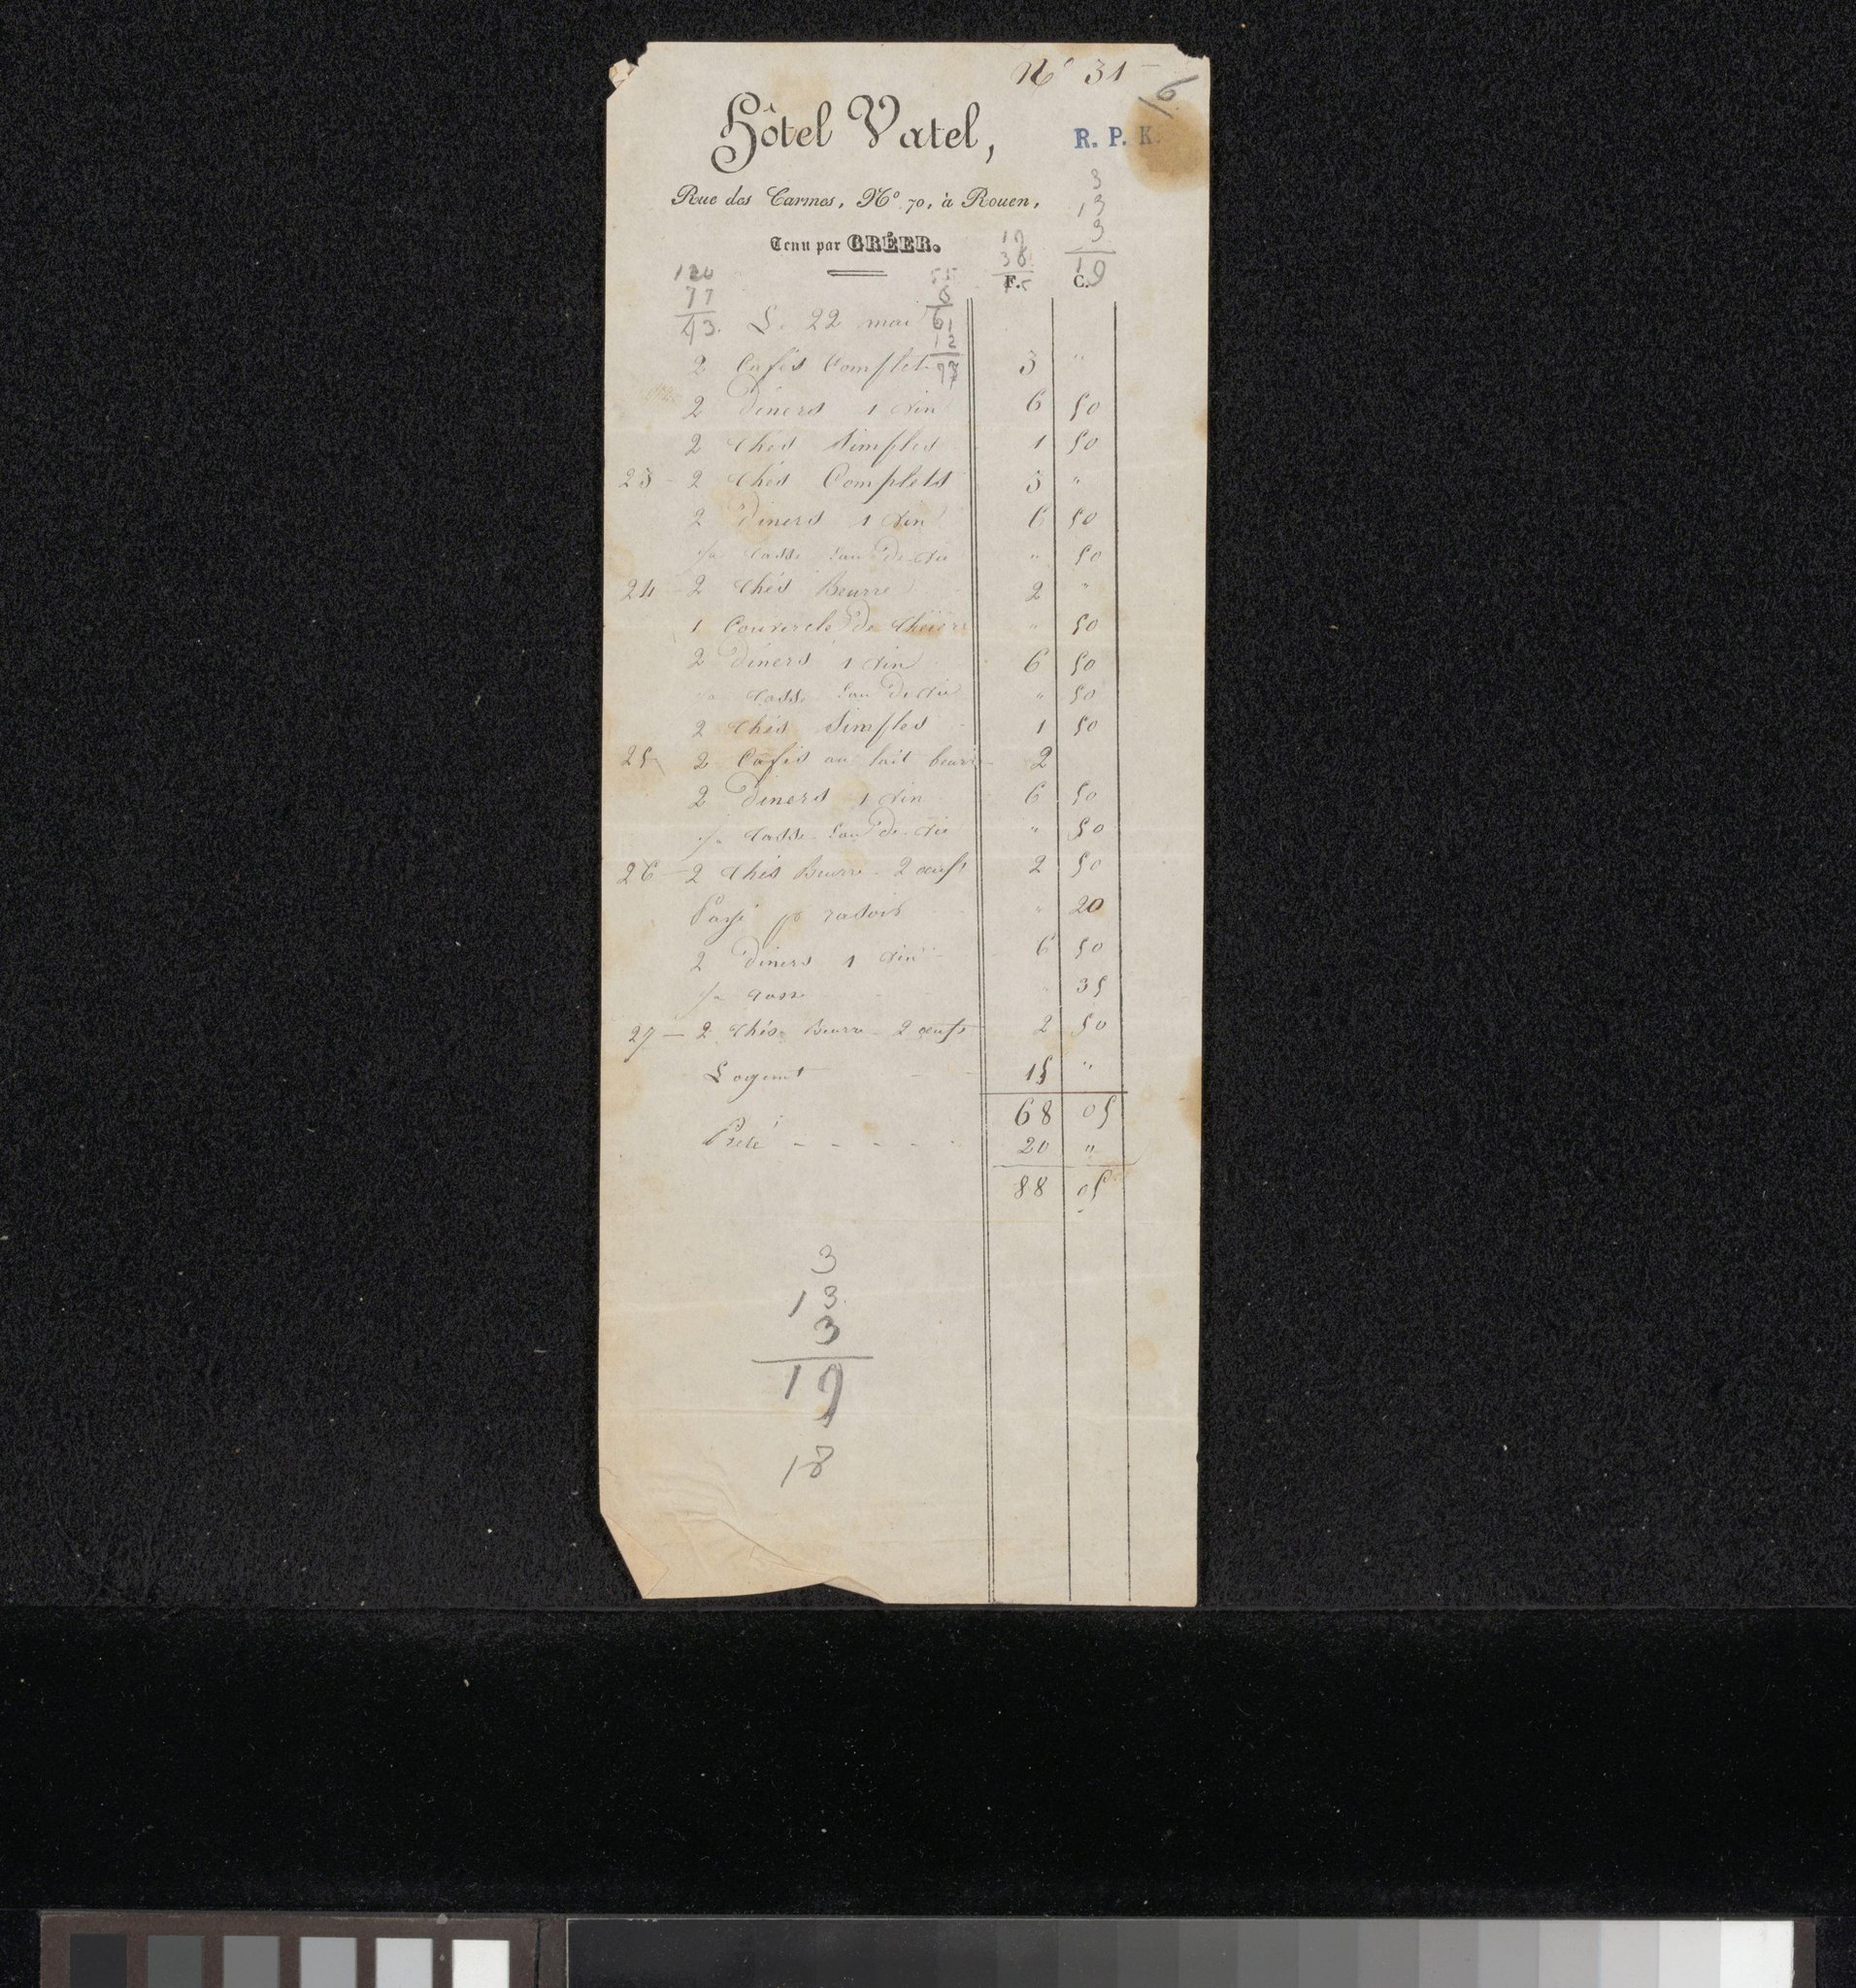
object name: account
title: Rekening voor Huib van Hove Bz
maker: Anonymous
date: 1824-1864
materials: ink, paper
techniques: pen, printing, writing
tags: the hague, antwerp, painter, huib van hove bz, money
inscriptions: collector's mark: Lugt 2233